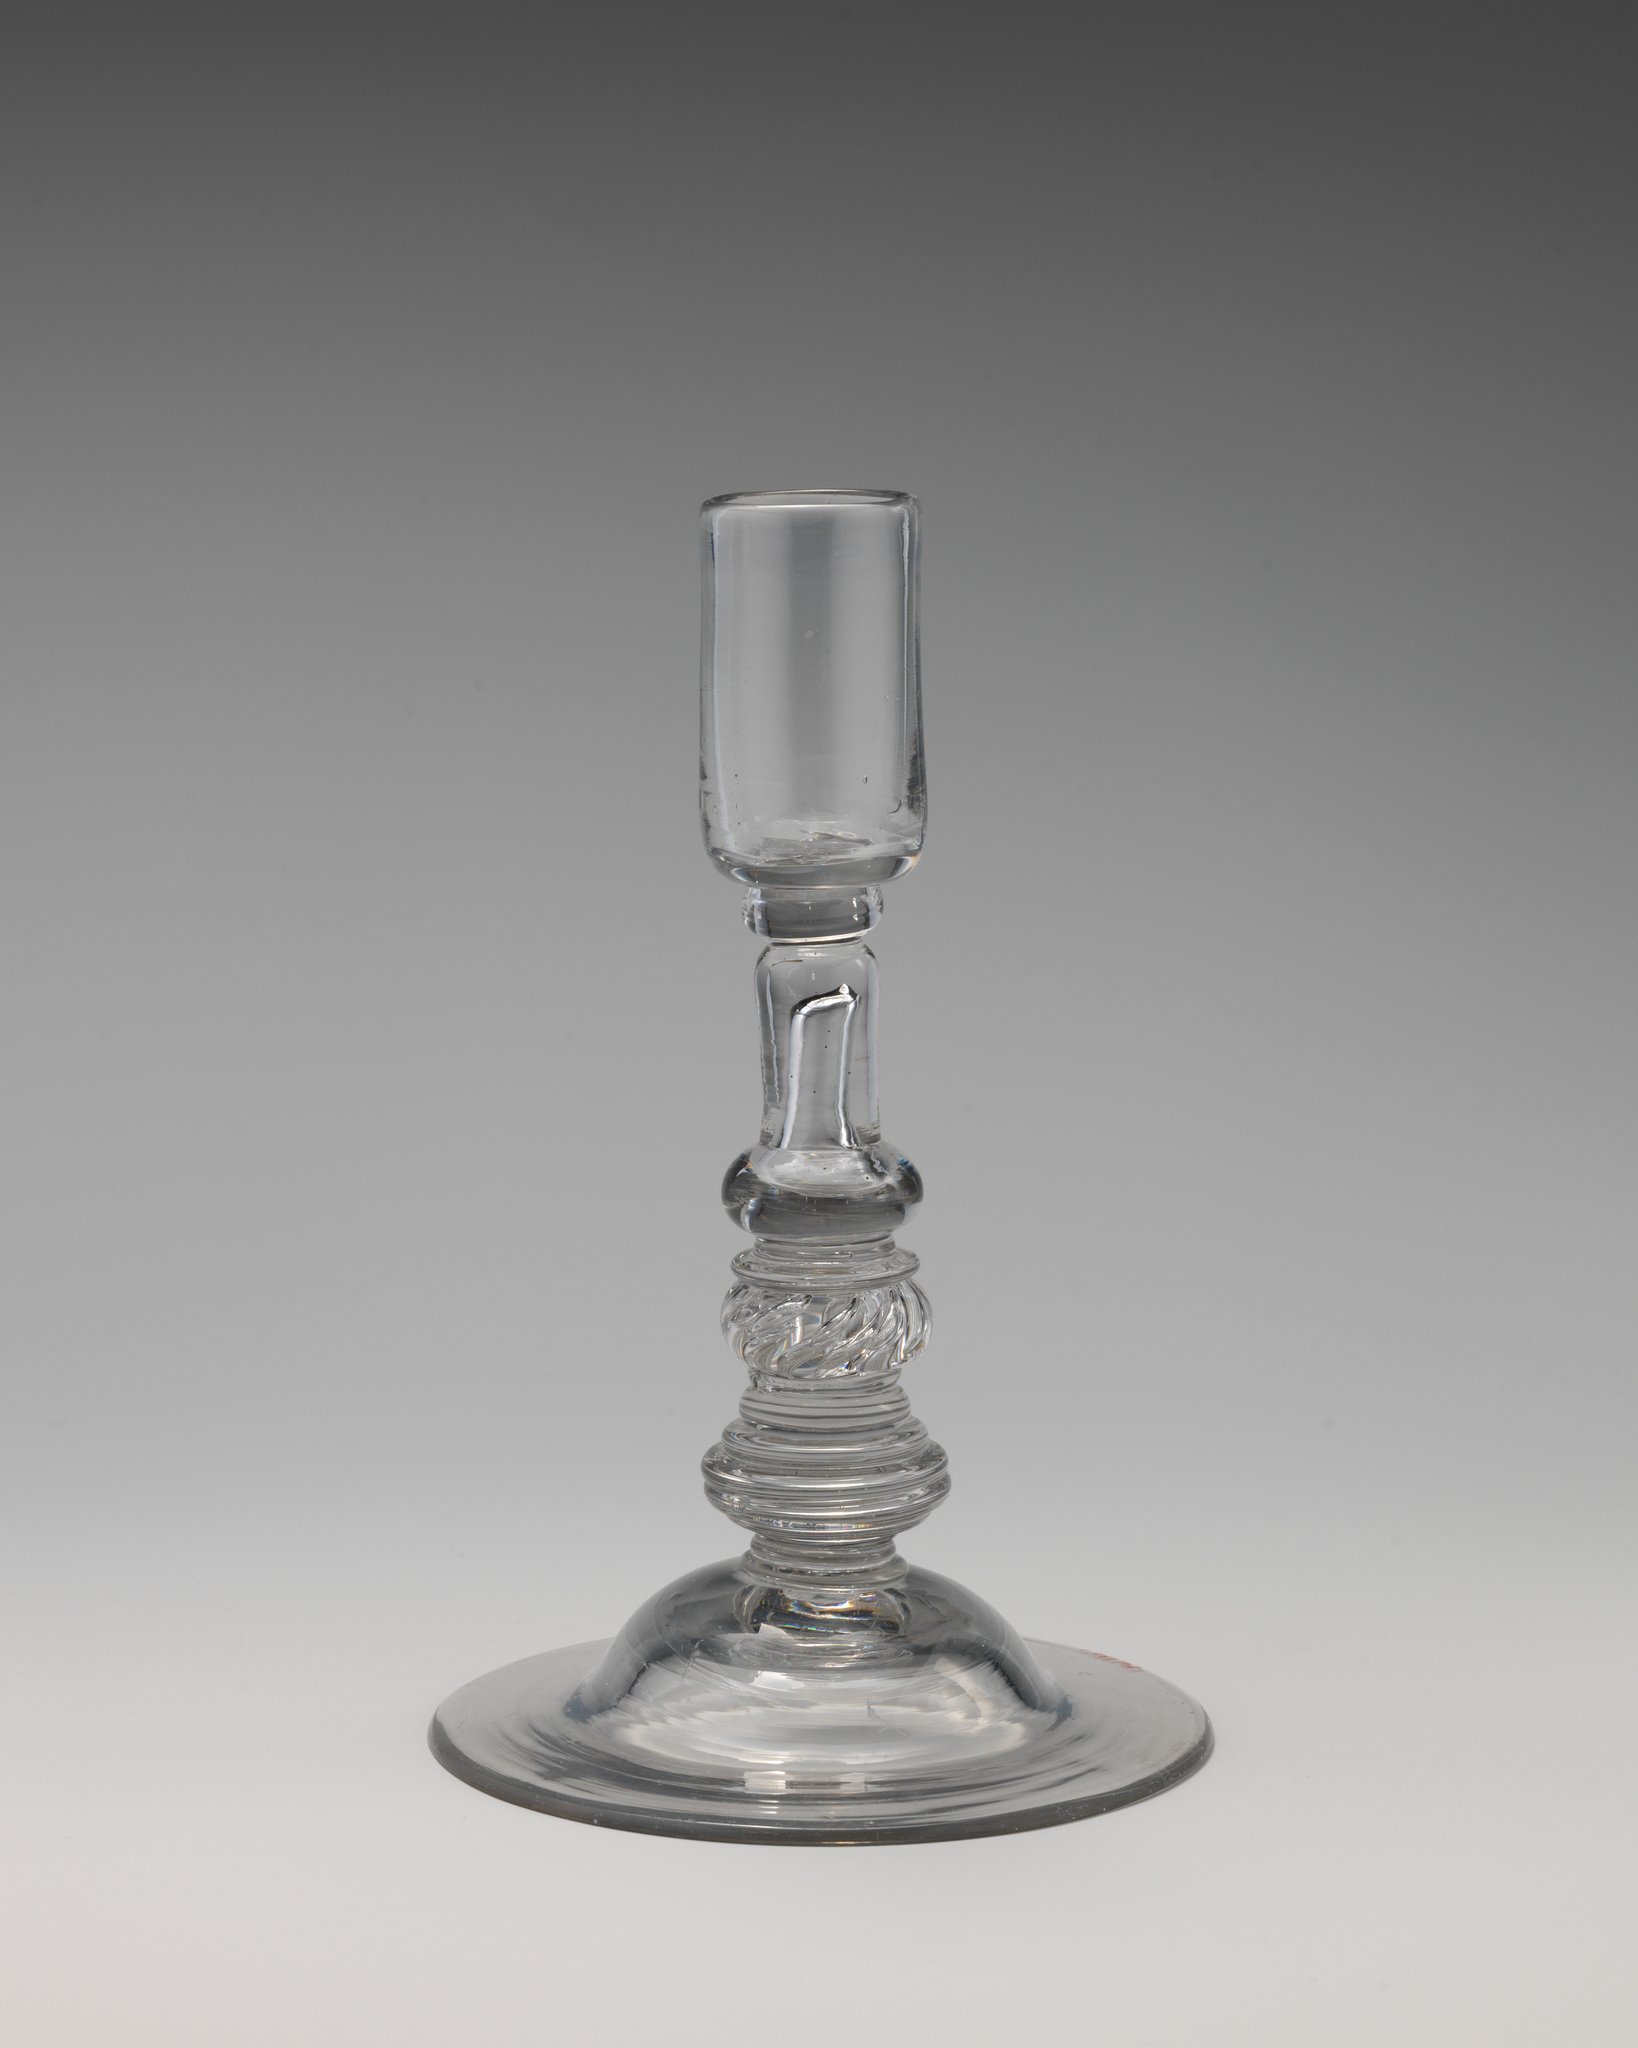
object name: candlestick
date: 1740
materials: glass